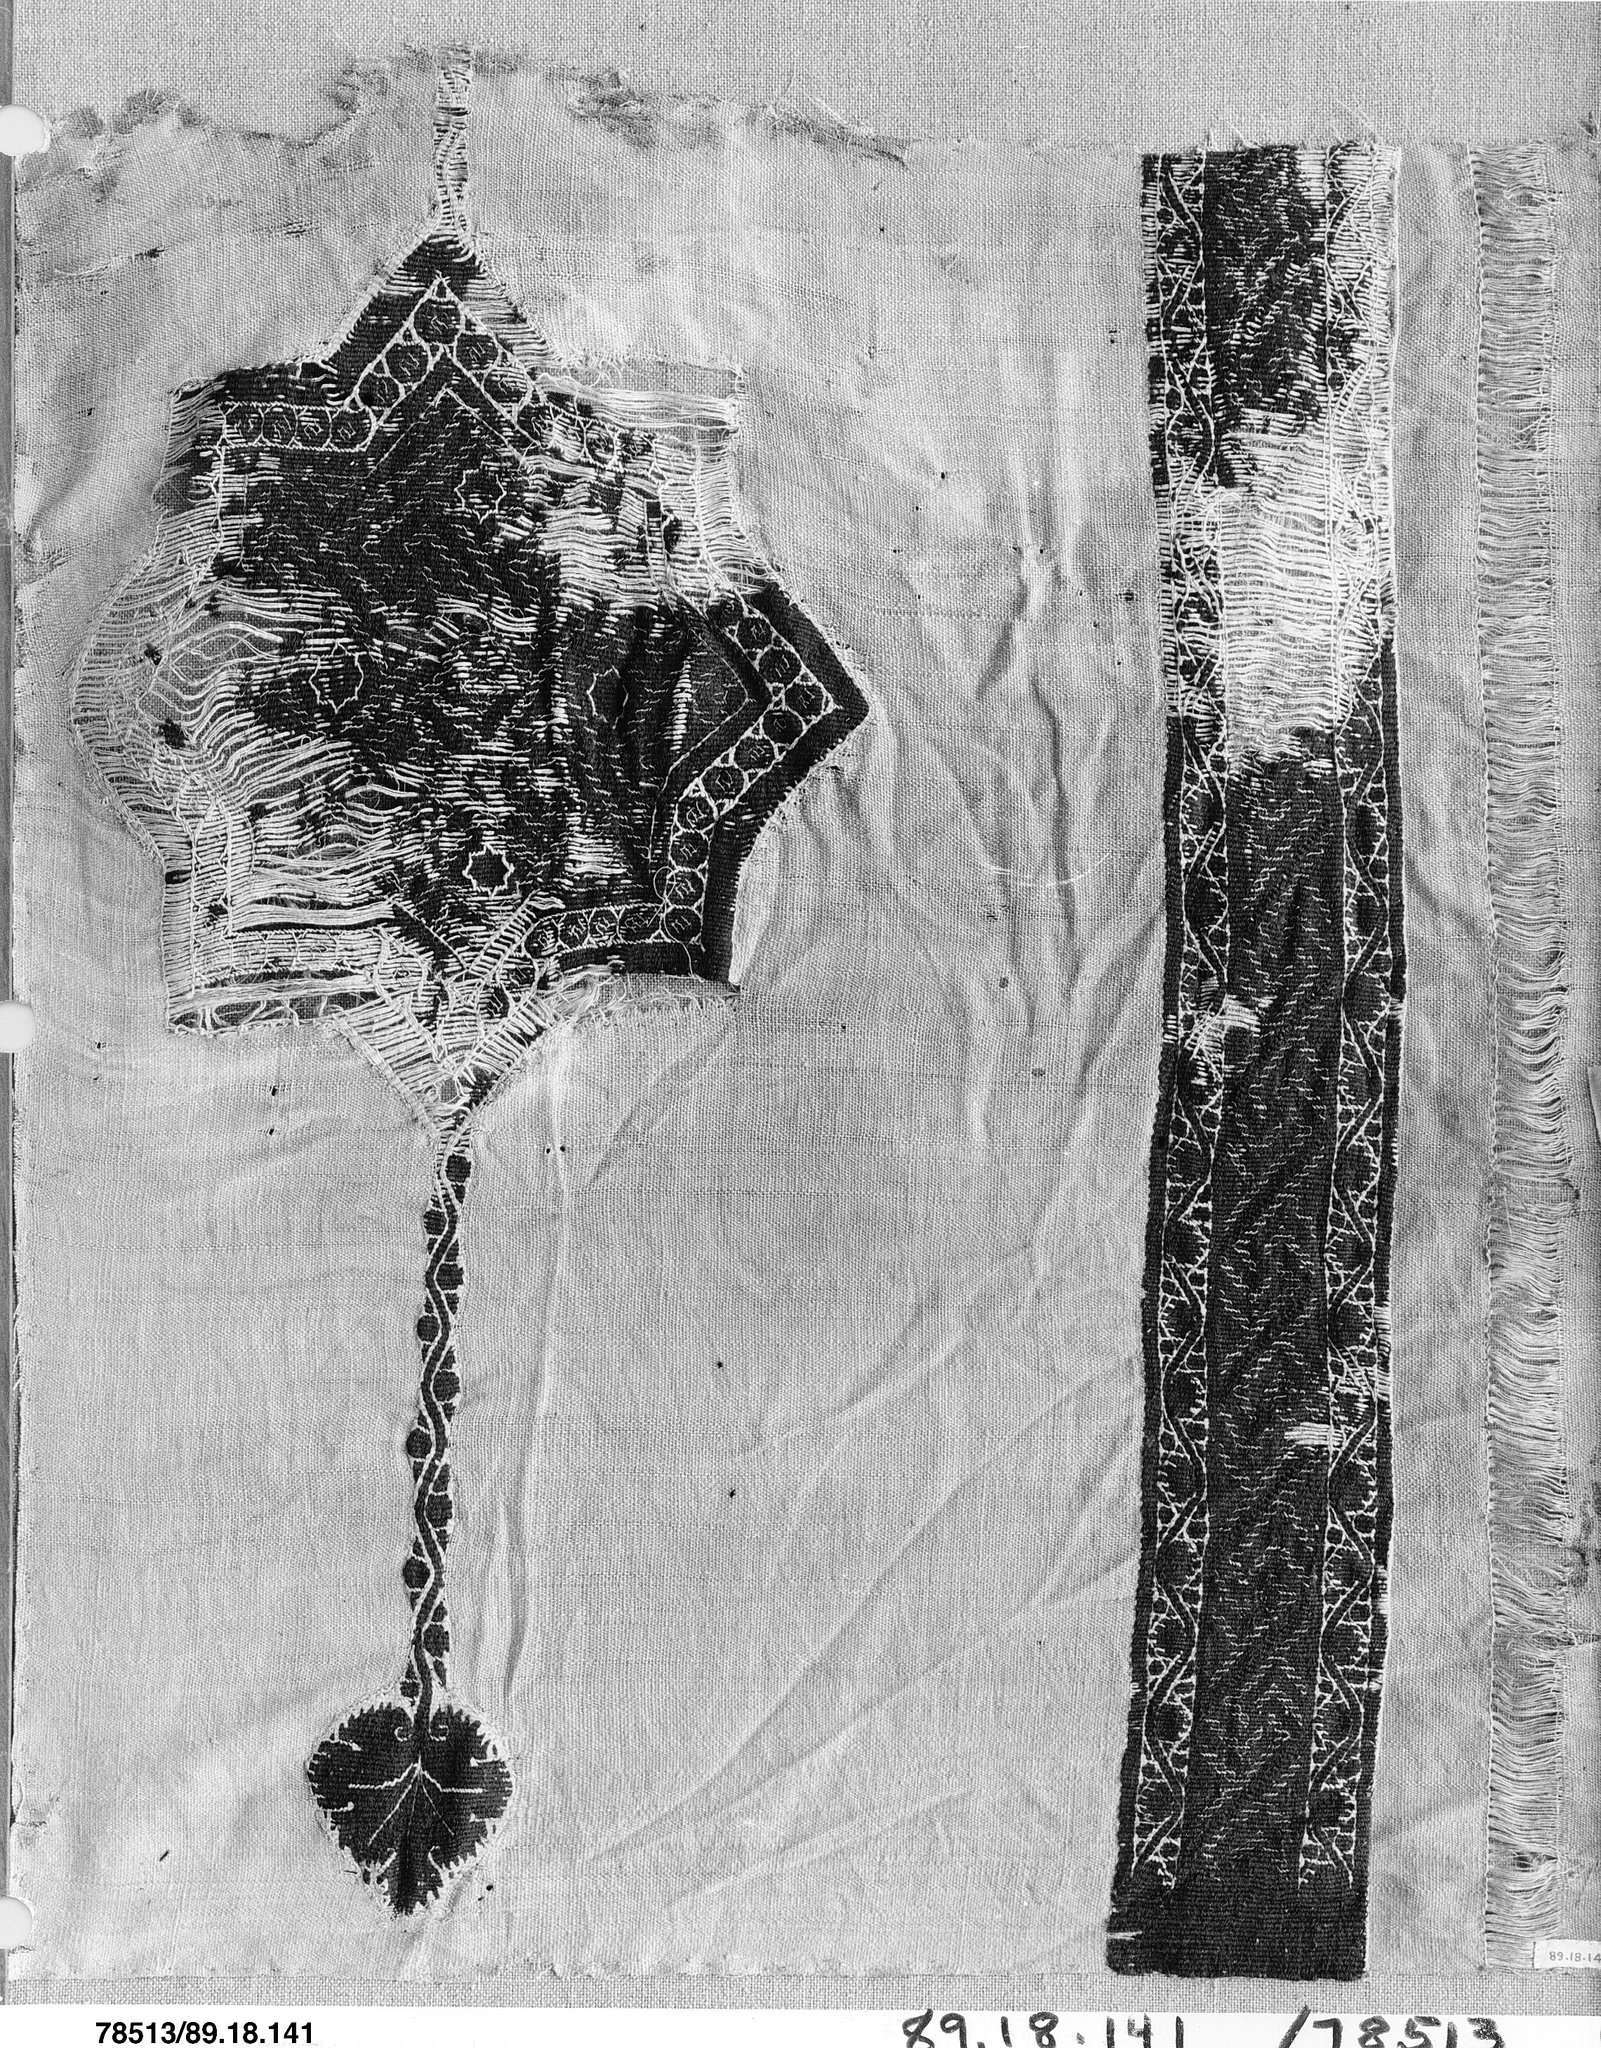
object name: textile fragment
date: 201-400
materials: linen, wool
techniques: weave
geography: egypt